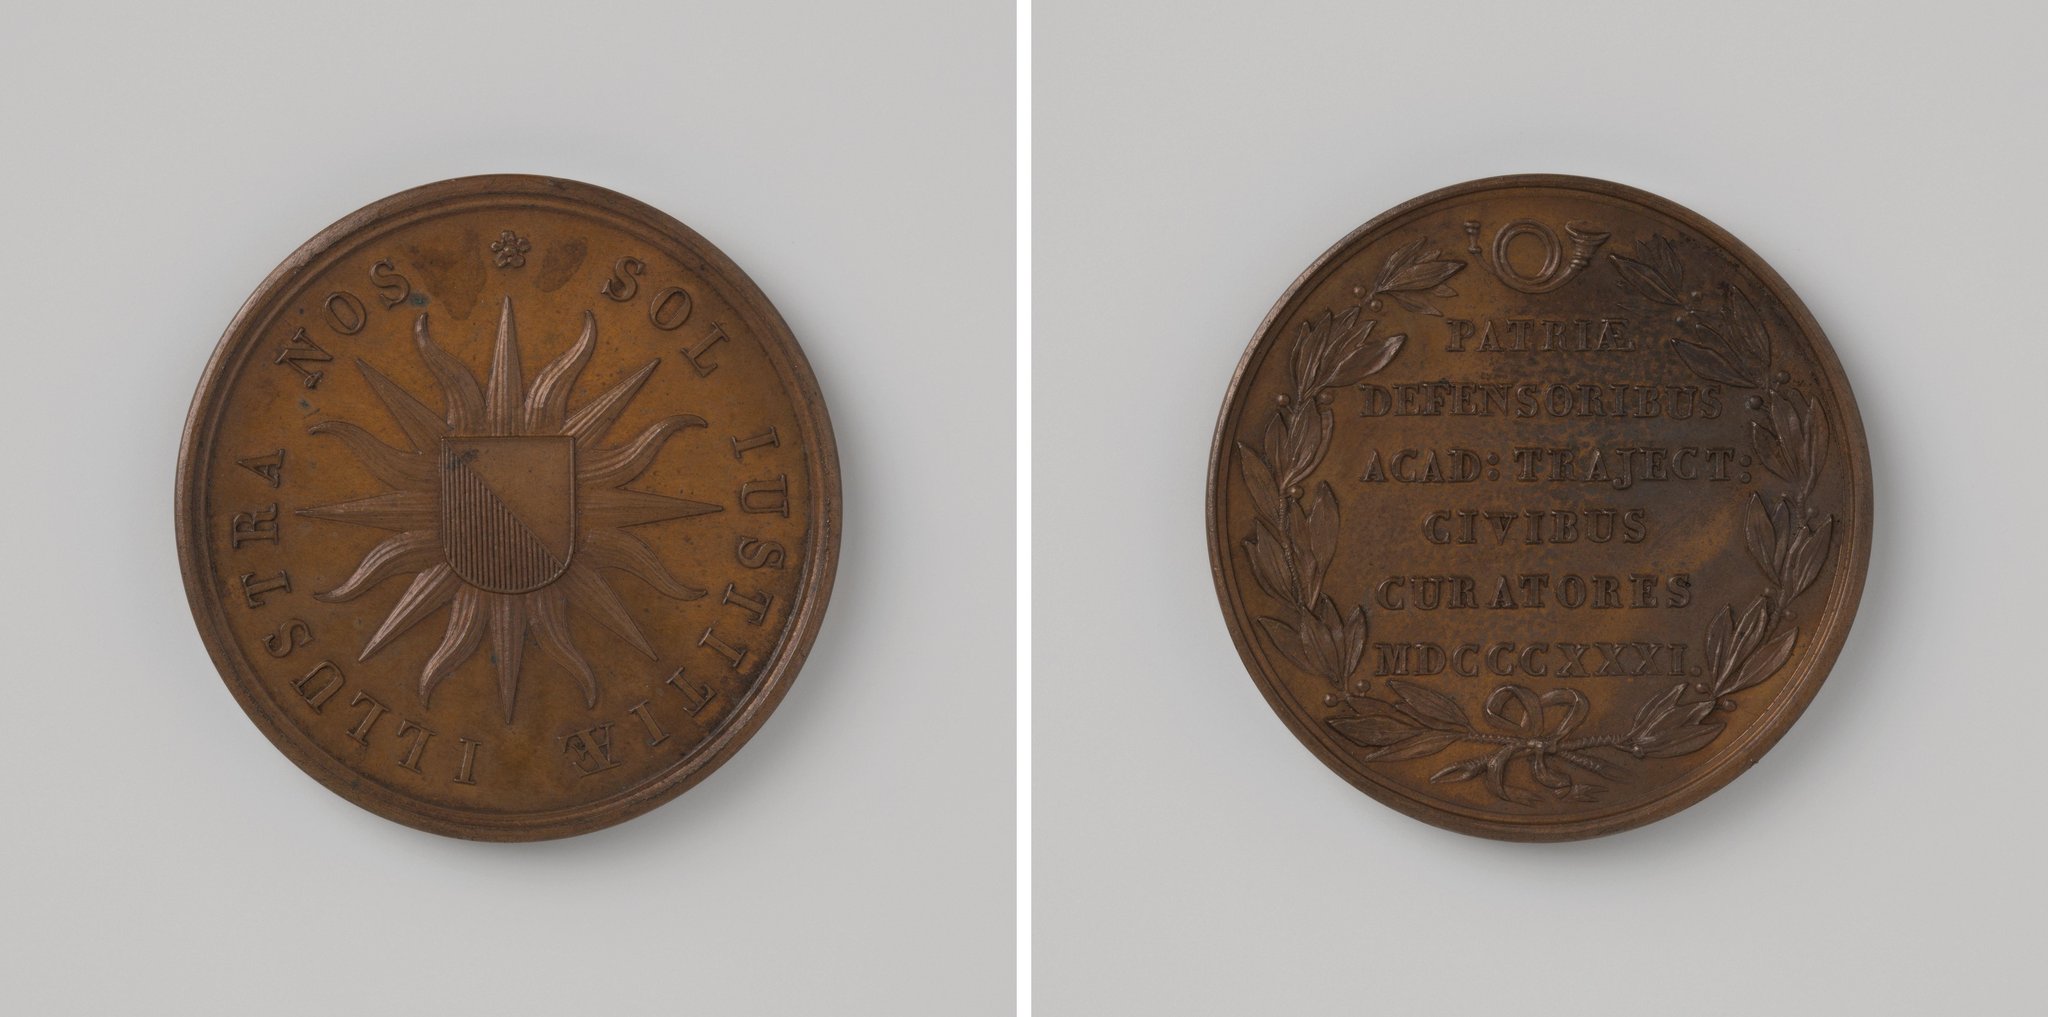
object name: history medal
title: Hulde van de Curatoren aan de uitgetrokken Utrechtse studenten 1831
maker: johannis petrus schouberg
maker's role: die cutter, draughtsman, print maker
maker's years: 1798-1864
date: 1831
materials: bronze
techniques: striking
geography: utrecht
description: Bronzen pennng, op de voorzijde een stralende zon waarop het Utrechtse stadswapen, met omschrift, op de keerzijde zes regels tekst onder een kleine hoorn, tussen samengestrikte lauwertakken.